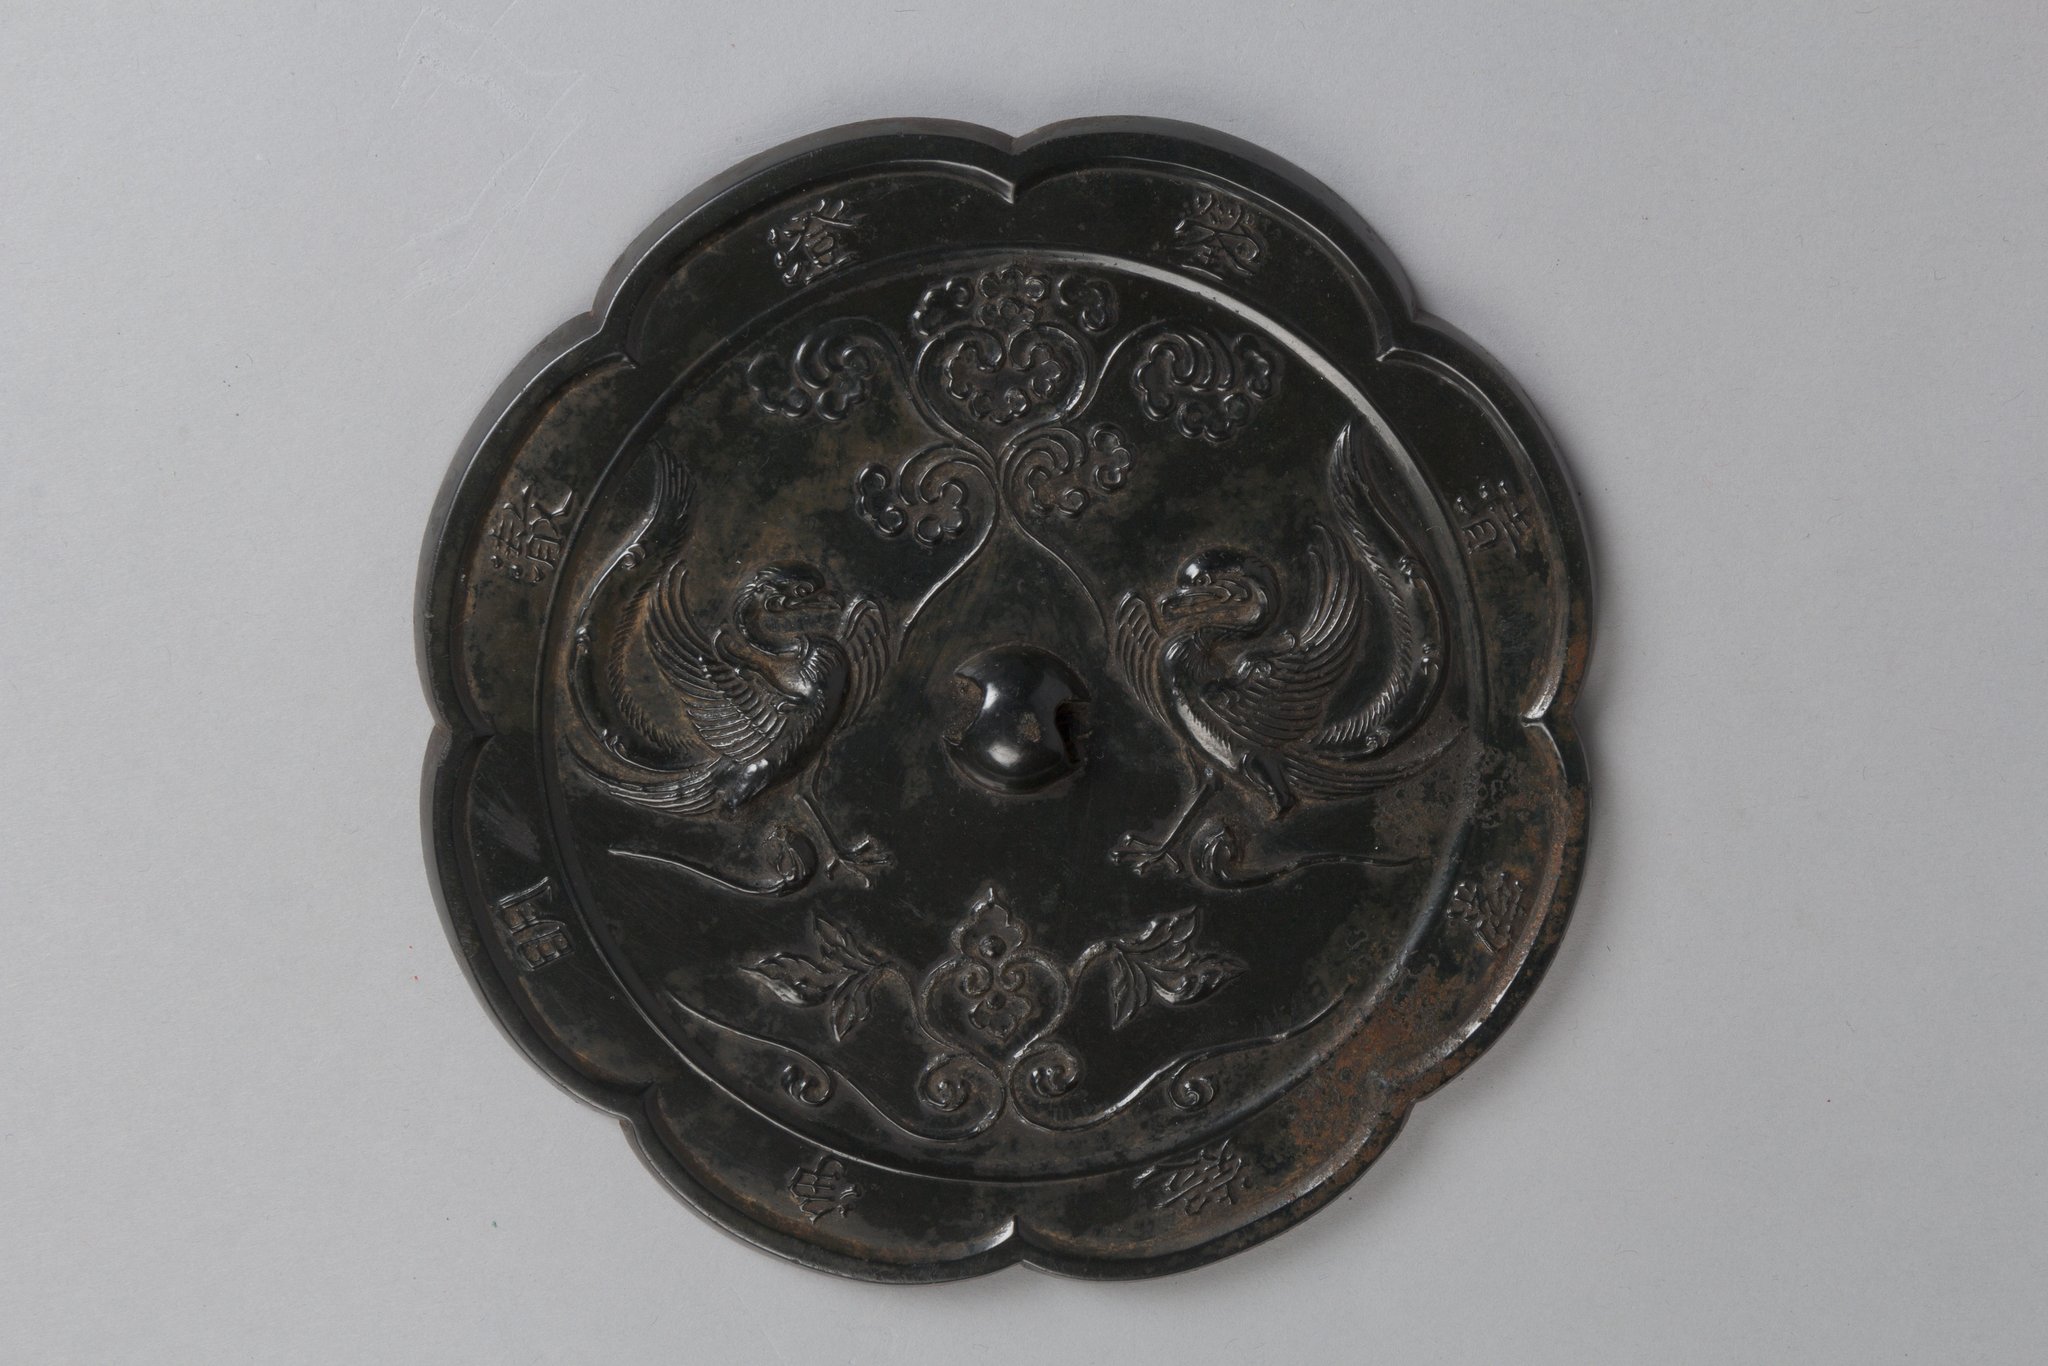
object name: mirror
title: Mirror with paired birds and floral designs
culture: chinese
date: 701-800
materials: bronze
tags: phoenix